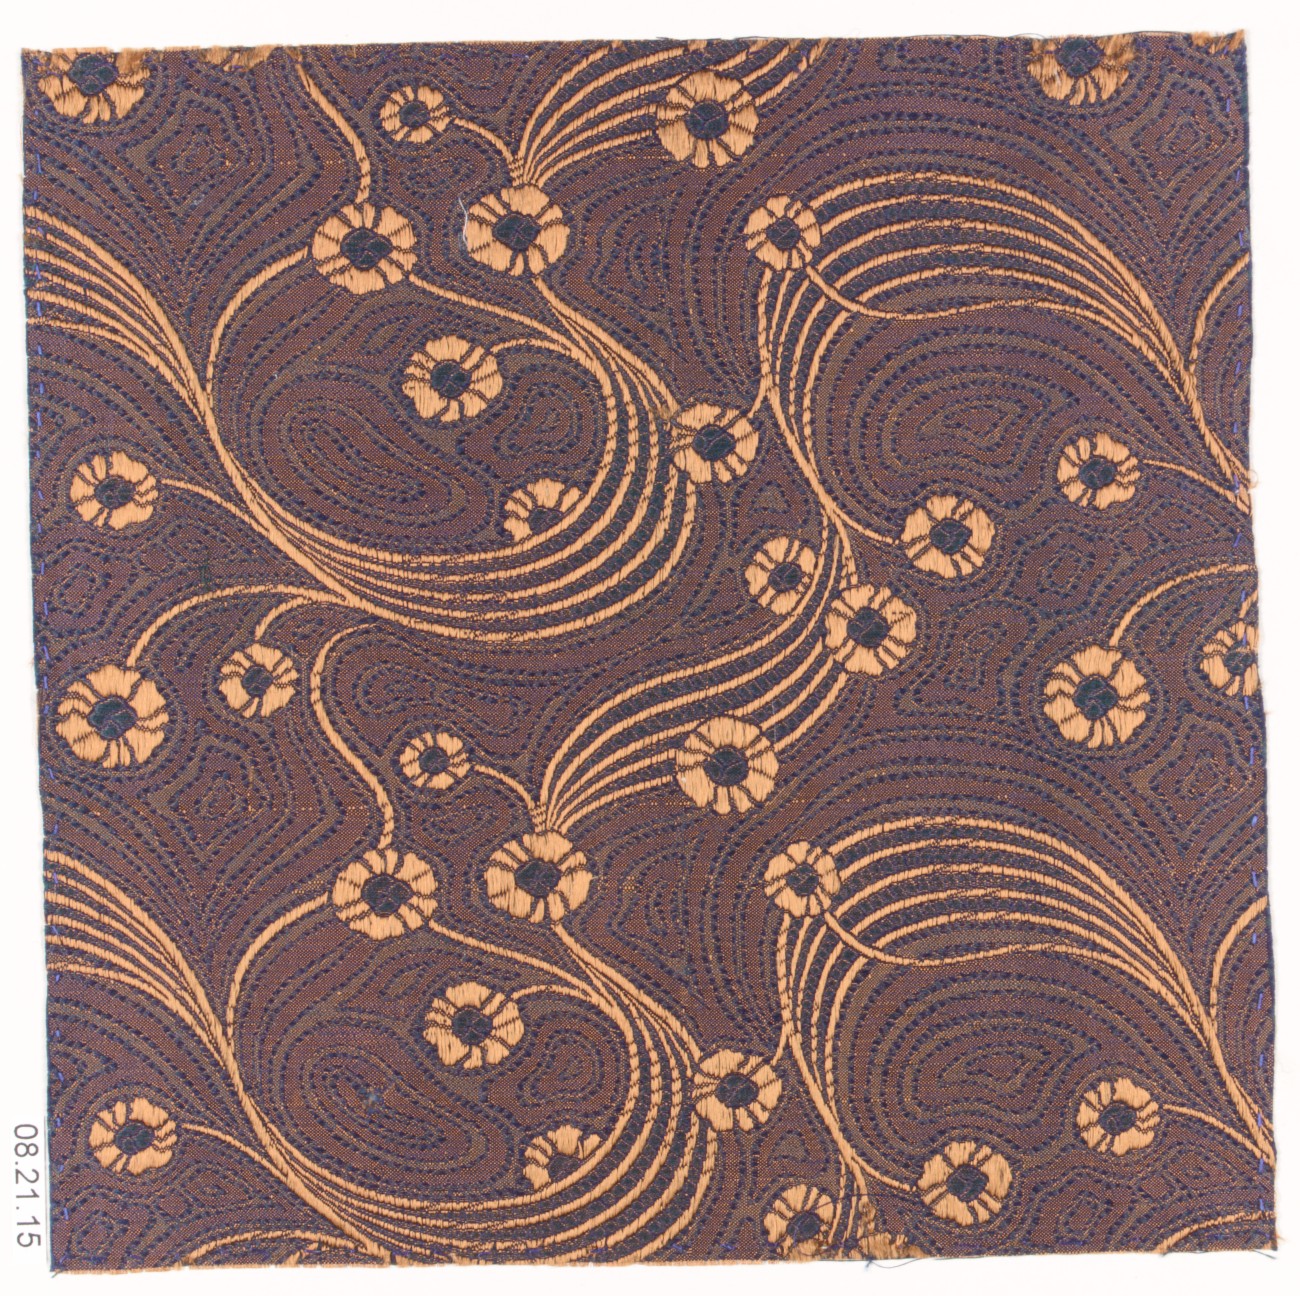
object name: textile sample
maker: Anonymous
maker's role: designer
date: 1900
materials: silk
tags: flowers